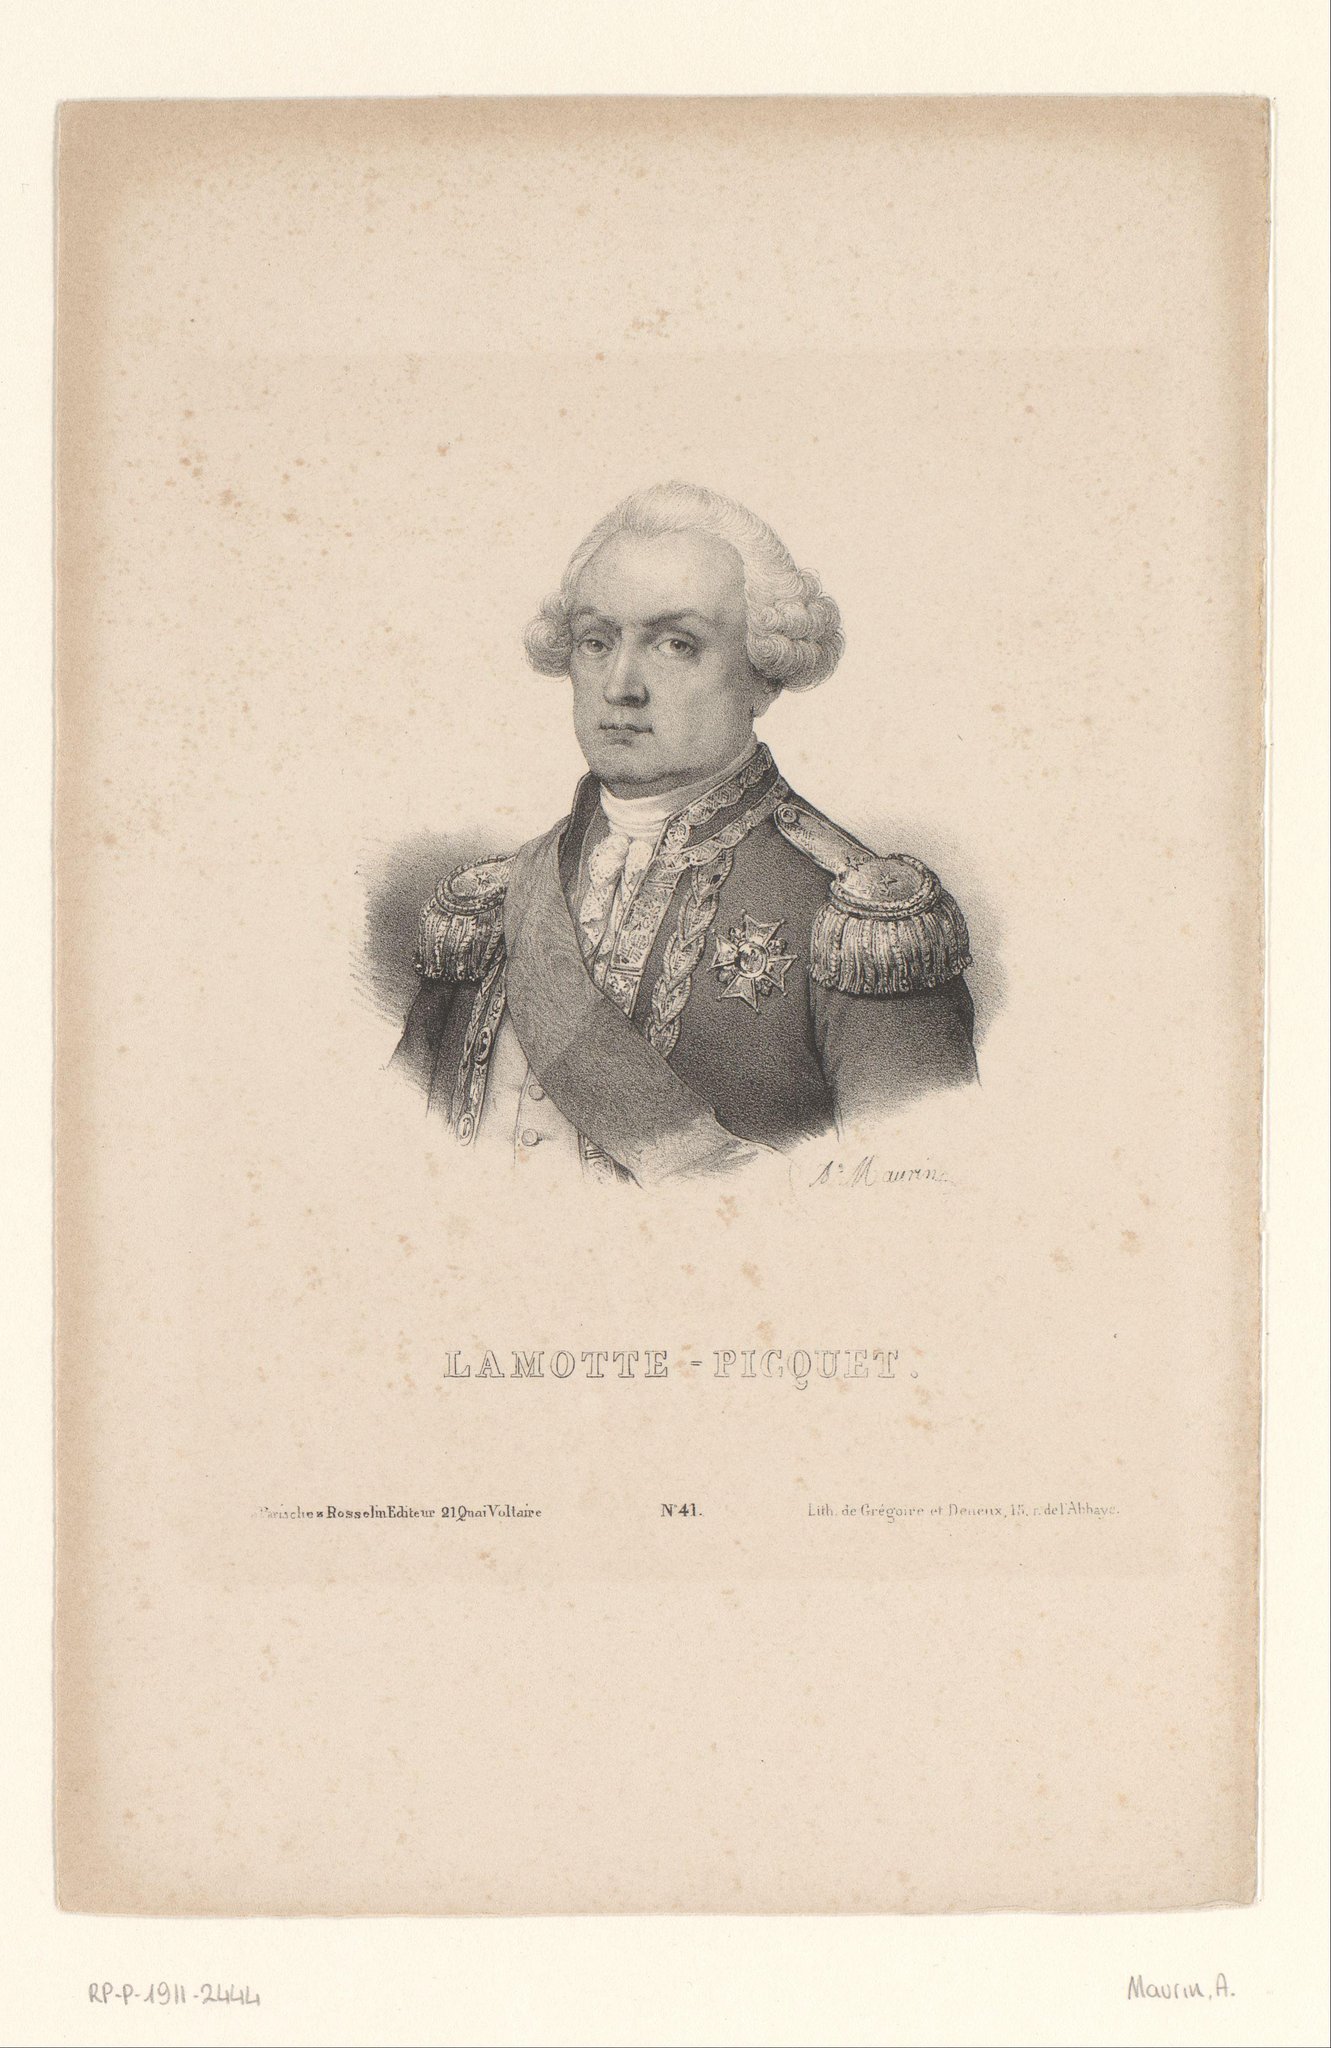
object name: print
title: Portret van Toussaint-Guillaume Picquet de la Motte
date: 1836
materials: paper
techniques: lithograph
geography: paris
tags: naval officer, historical persons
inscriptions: collector's mark: Lugt 2228